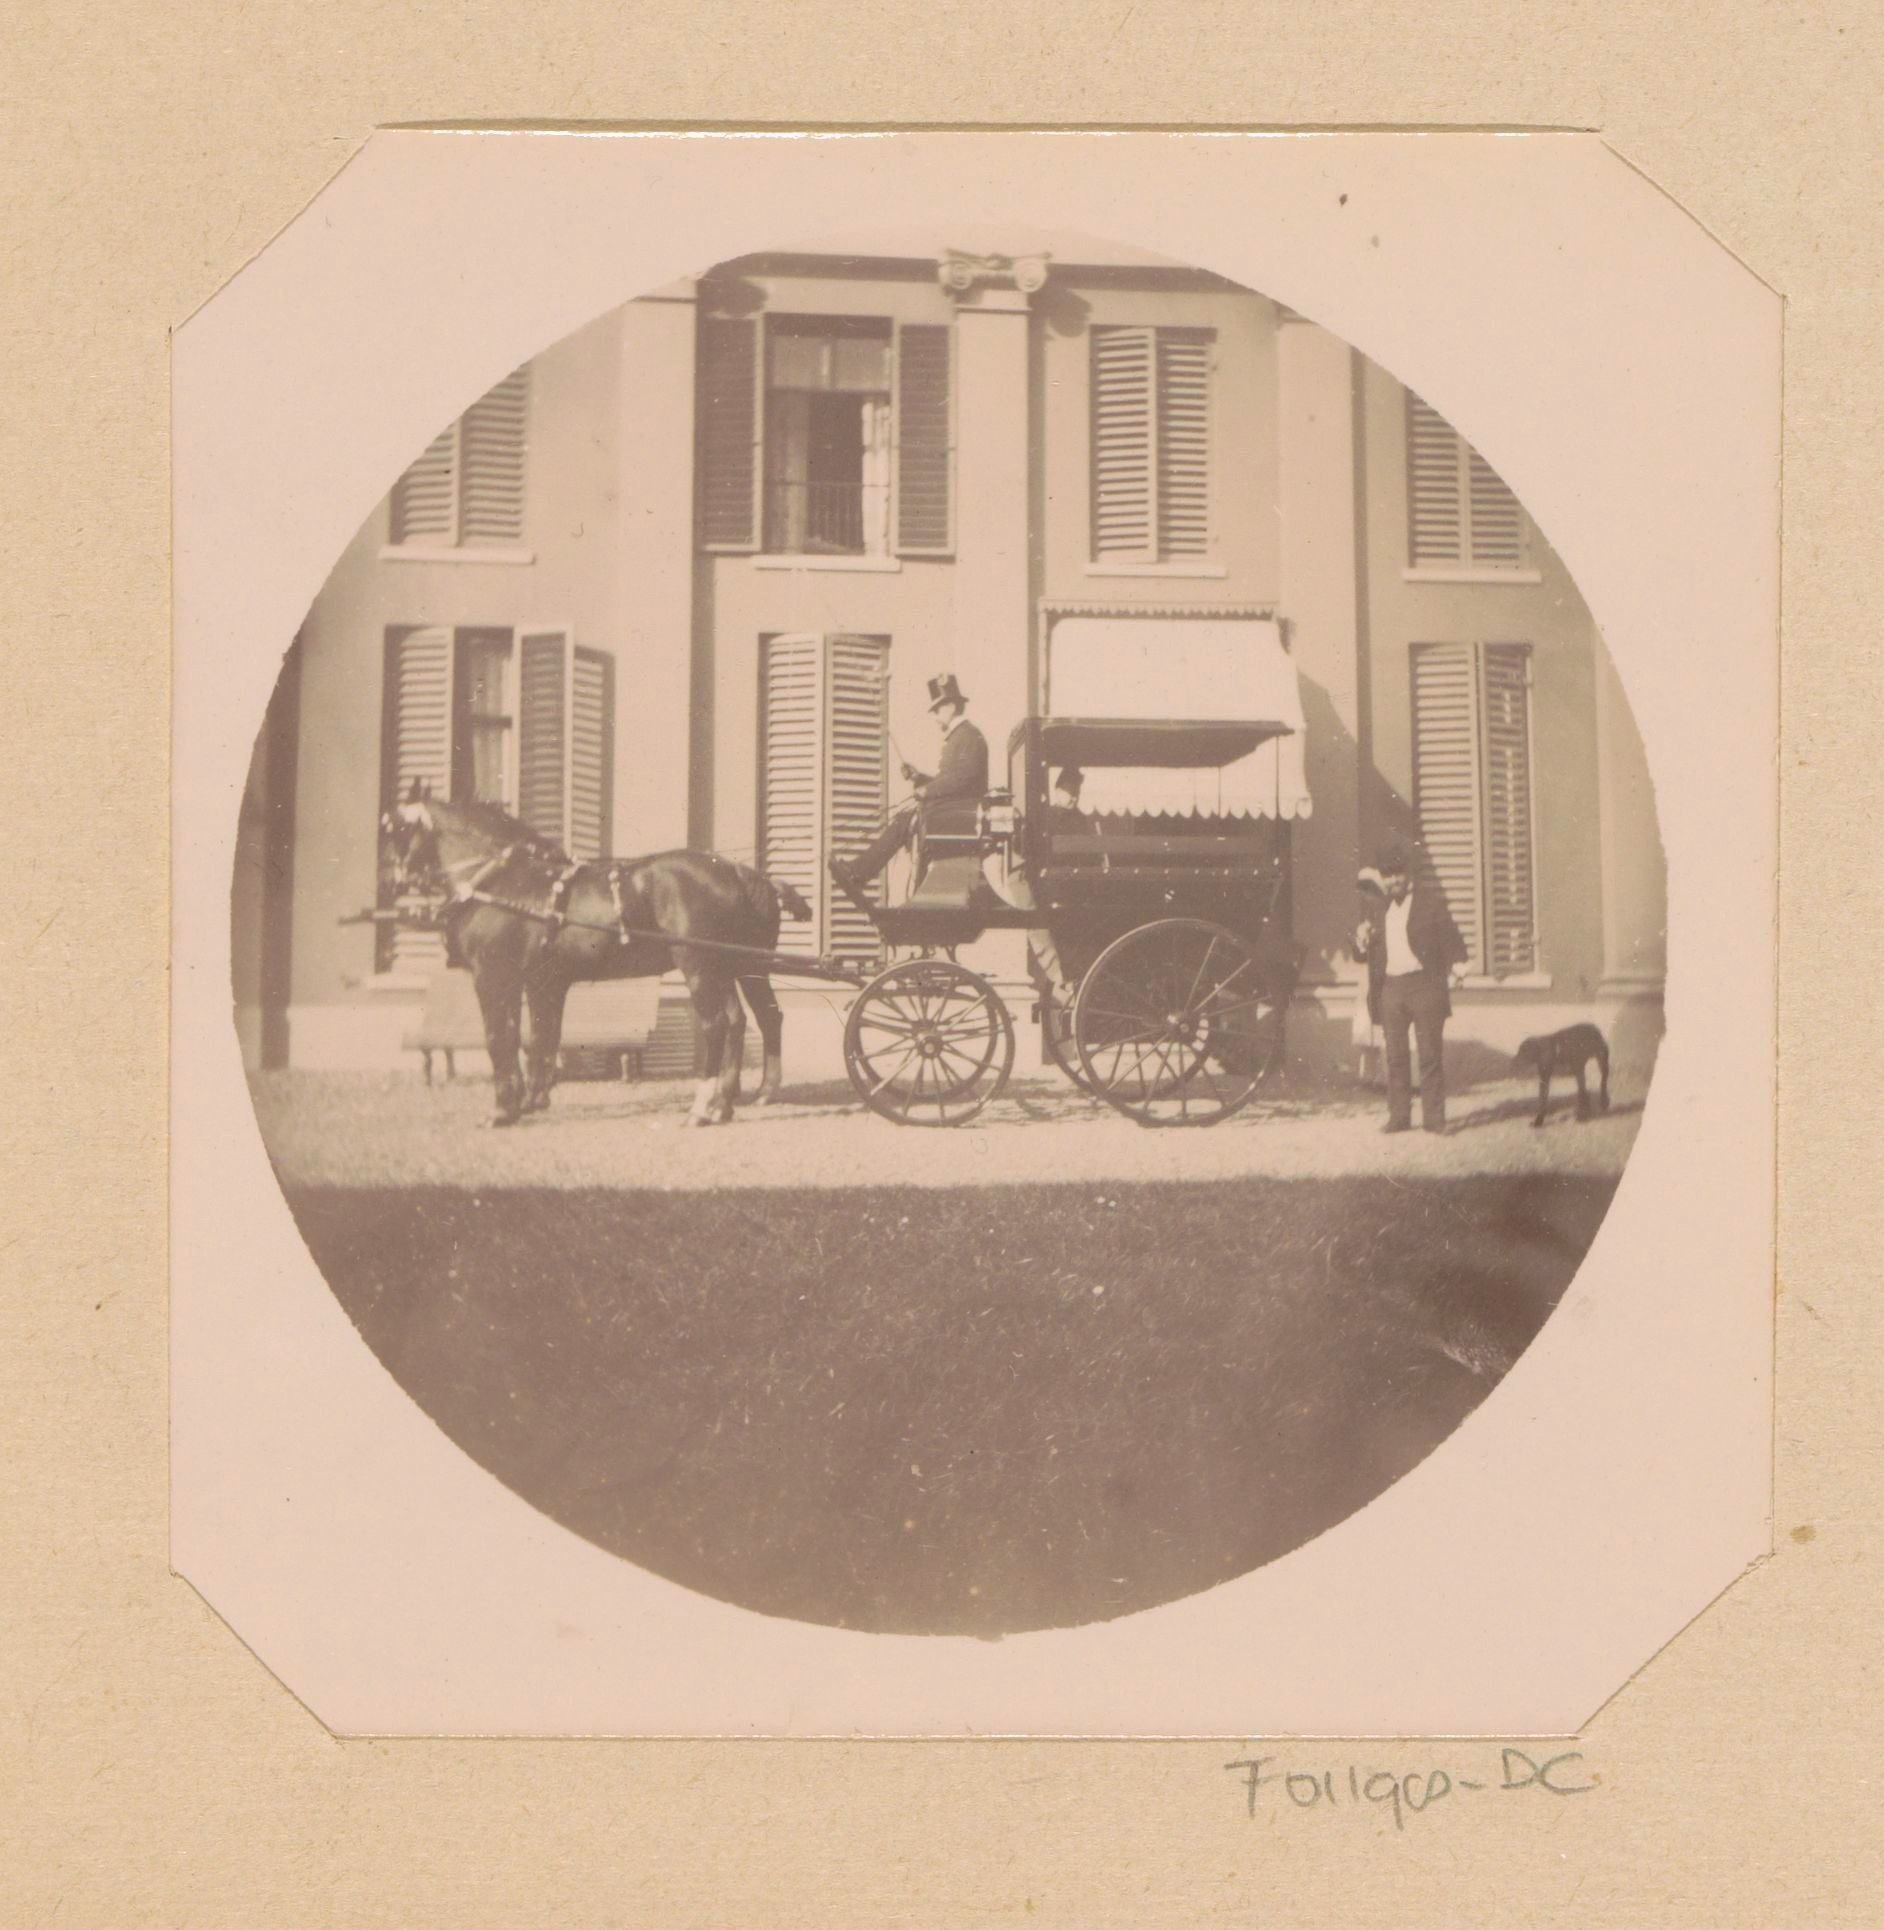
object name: photograph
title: Rijtuig wachtend voor een huis, mogelijk Groot Warnsborn nabij Arnhem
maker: johanna margaretha piek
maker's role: fotograaf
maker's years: 1870-1947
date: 1889-1893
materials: paper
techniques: gelatin silver print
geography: arnhem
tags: animal traction, animal-drawn vehicle (carriage etc.)